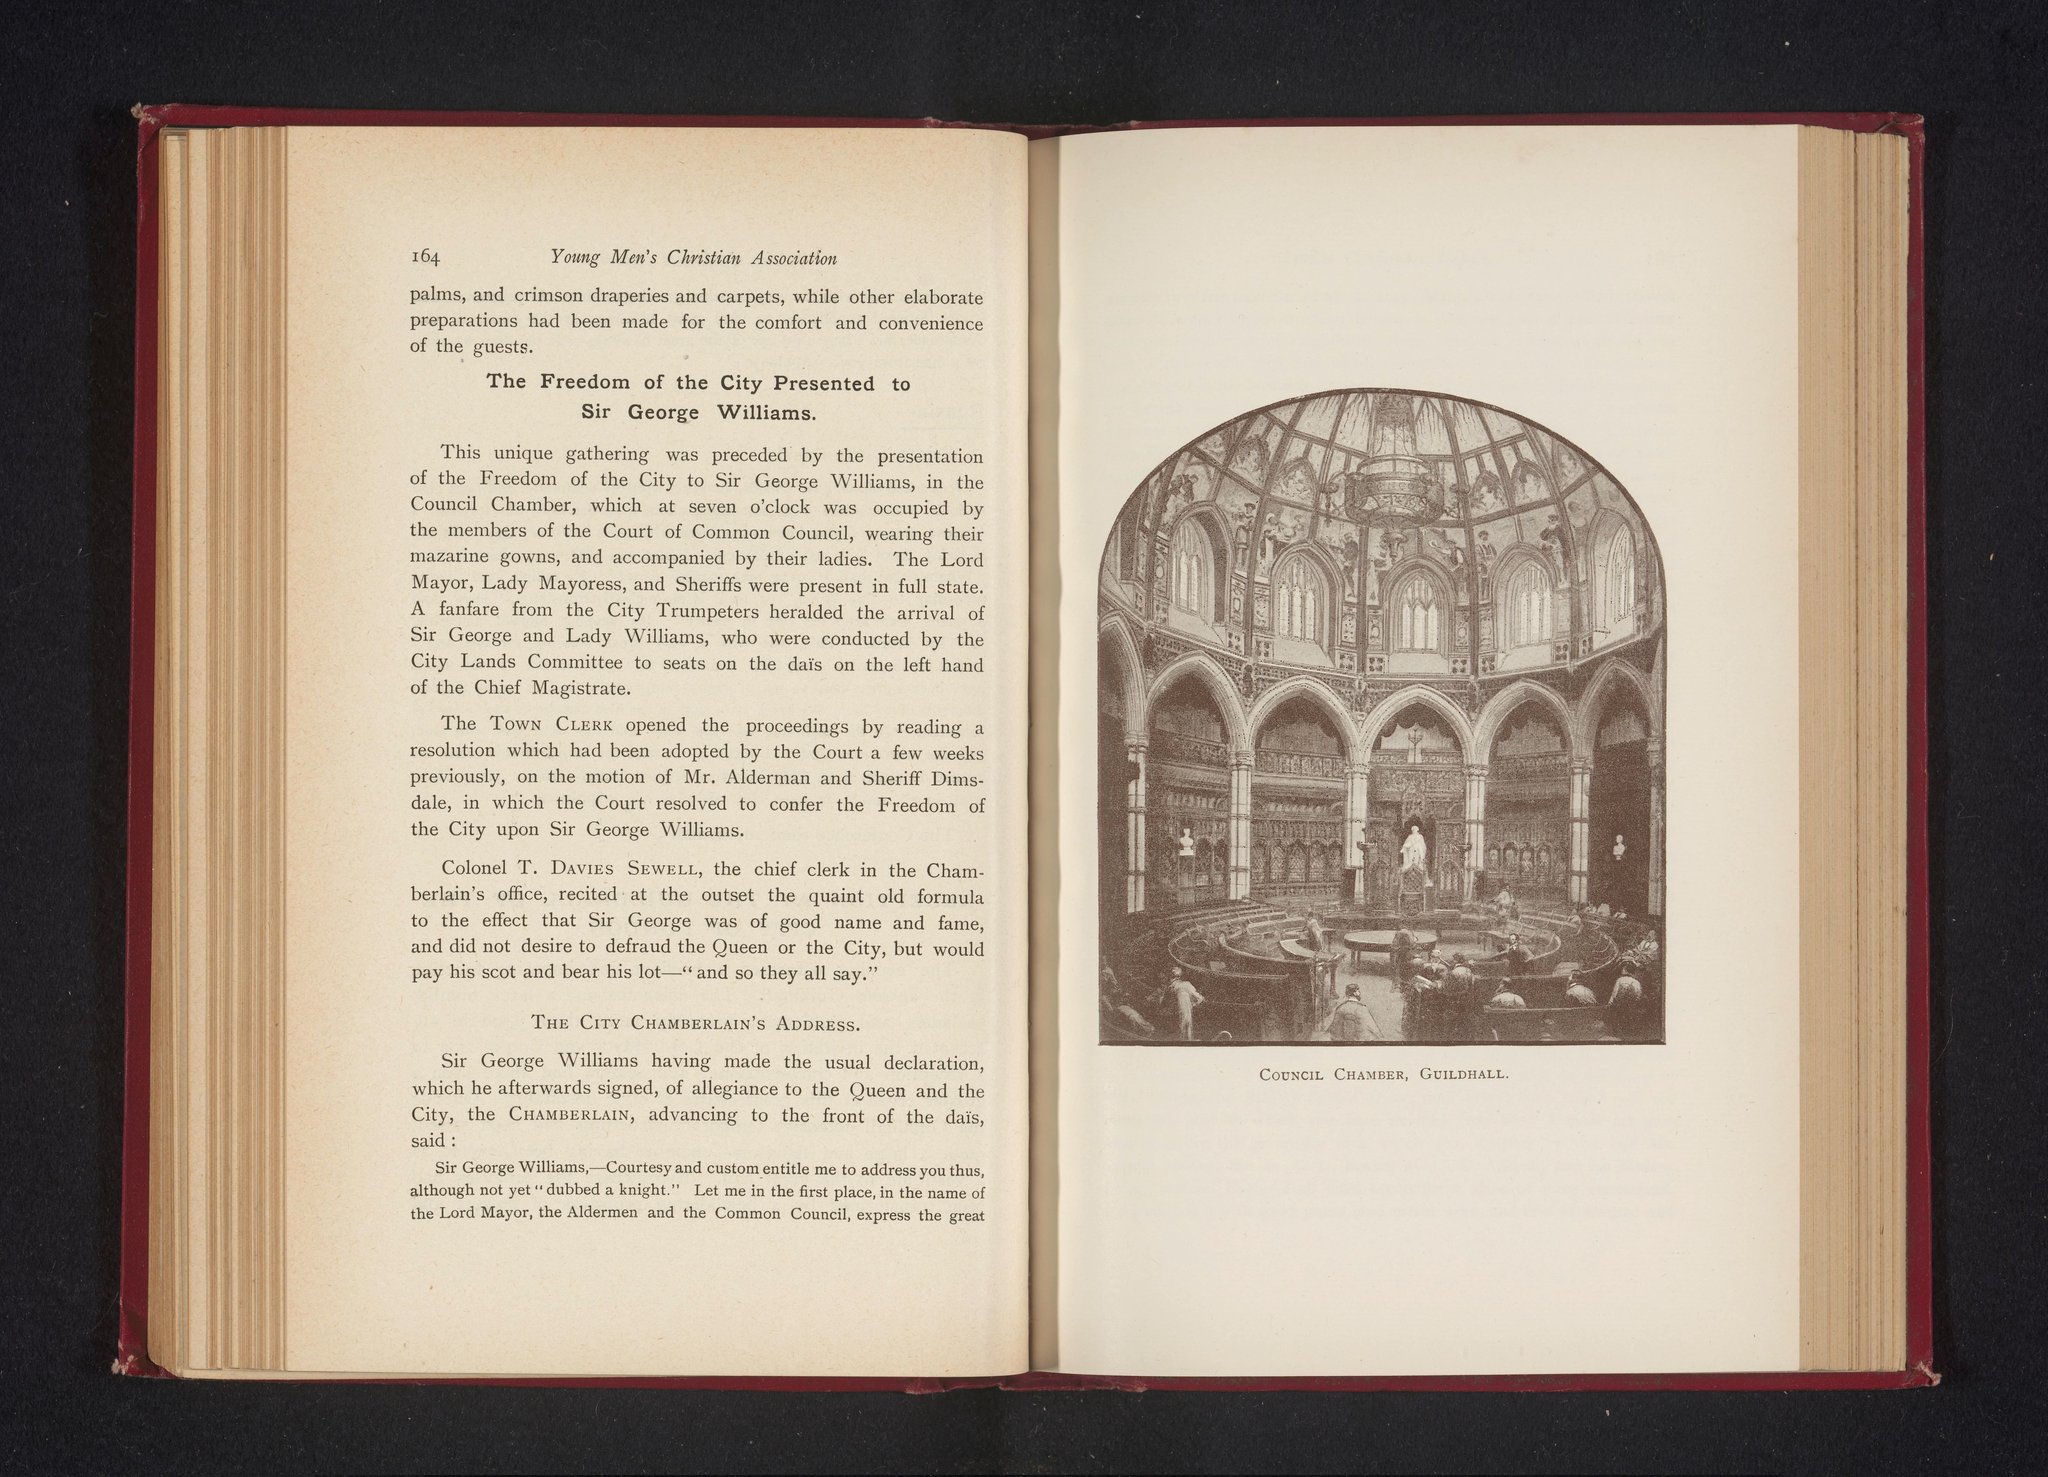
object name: photomechanical print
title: Council Chamber, Guildhall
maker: Anonymous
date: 1890-1895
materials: paper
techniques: autotype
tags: city council, townhall